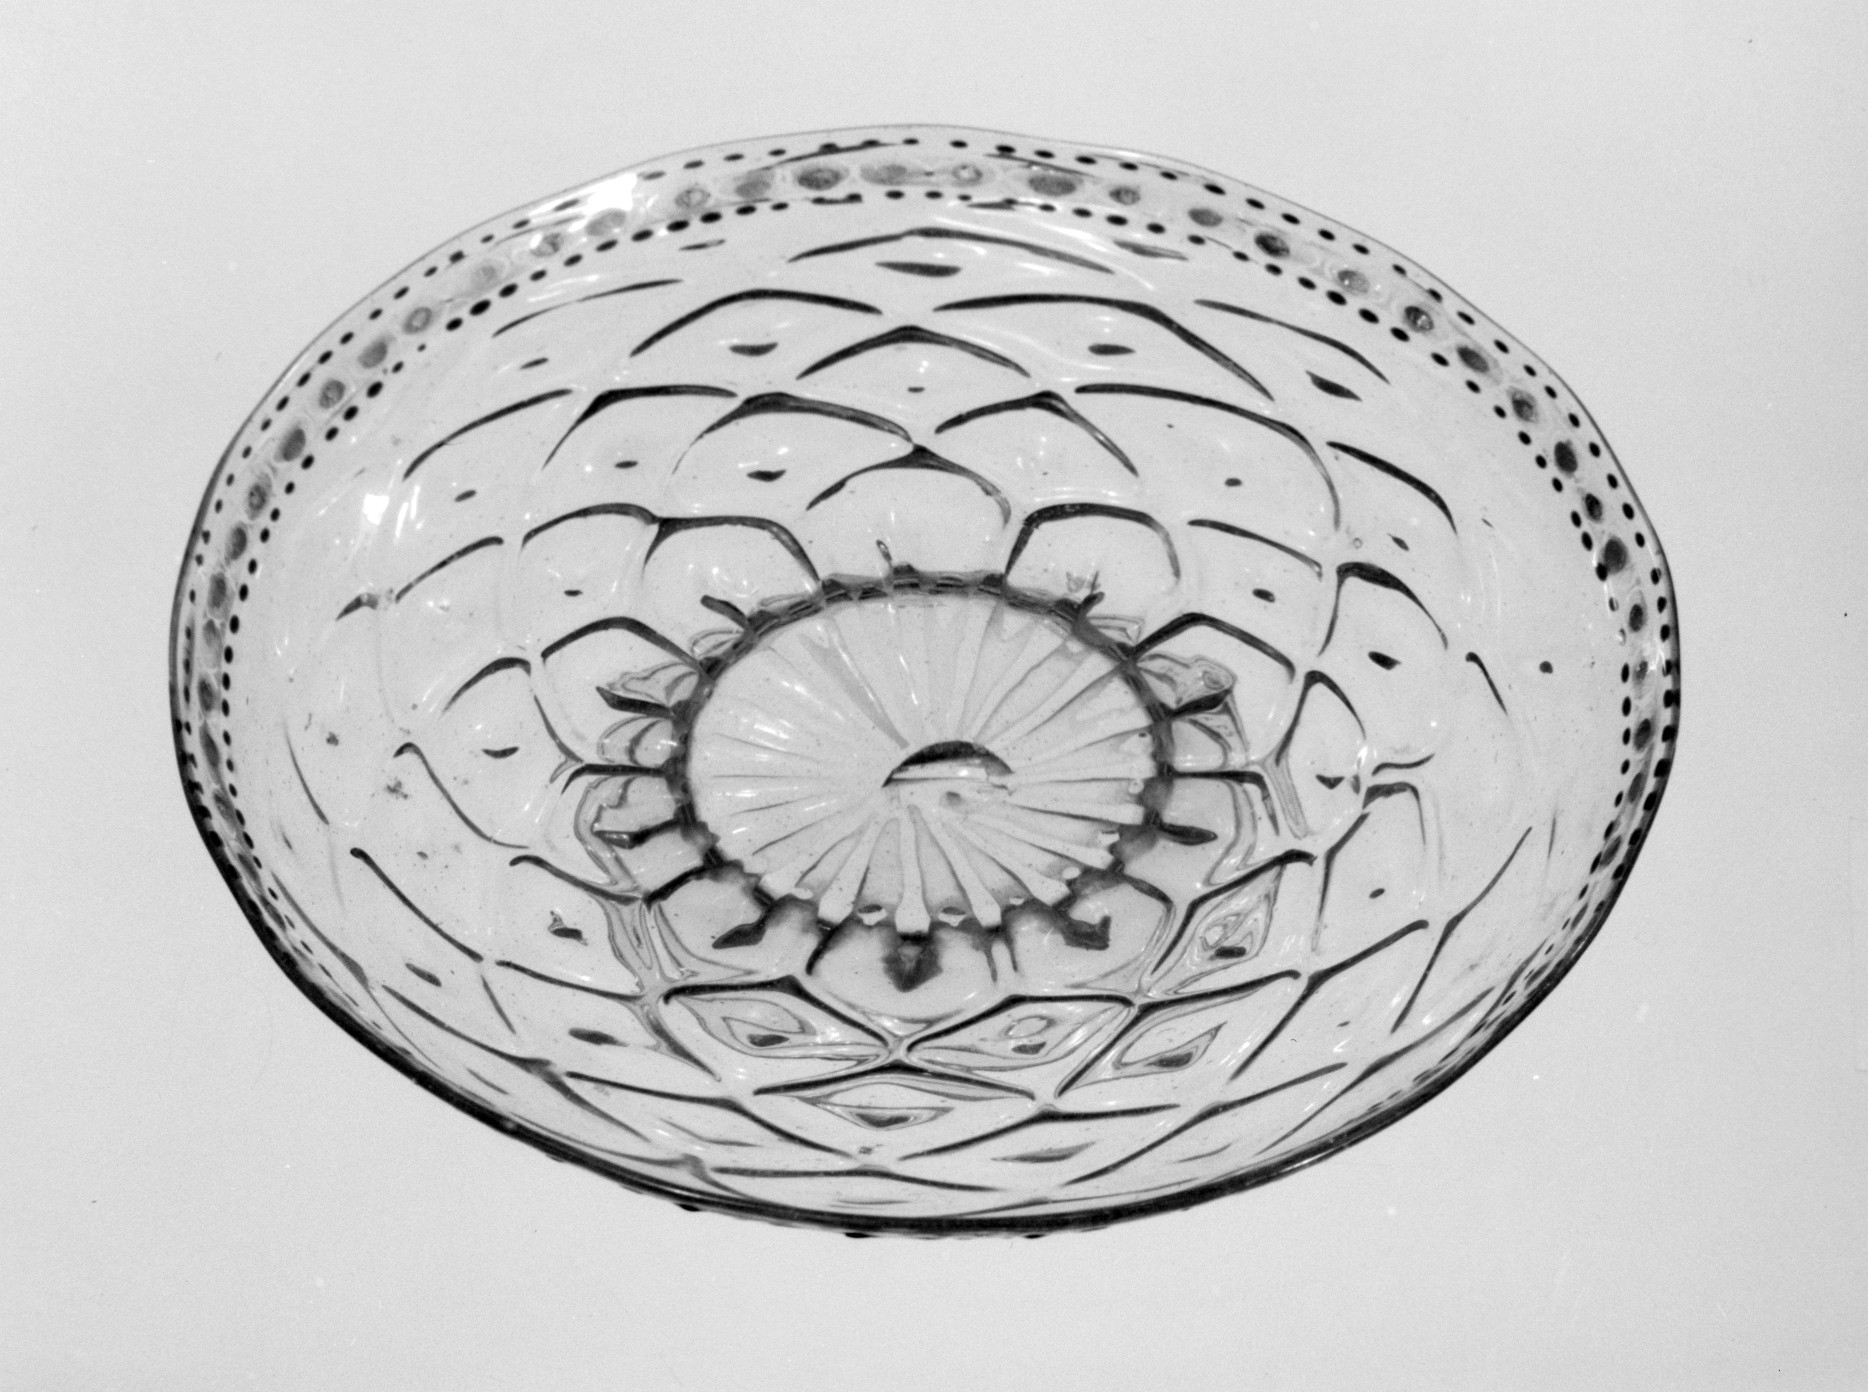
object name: tazza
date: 1501-1600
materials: glass